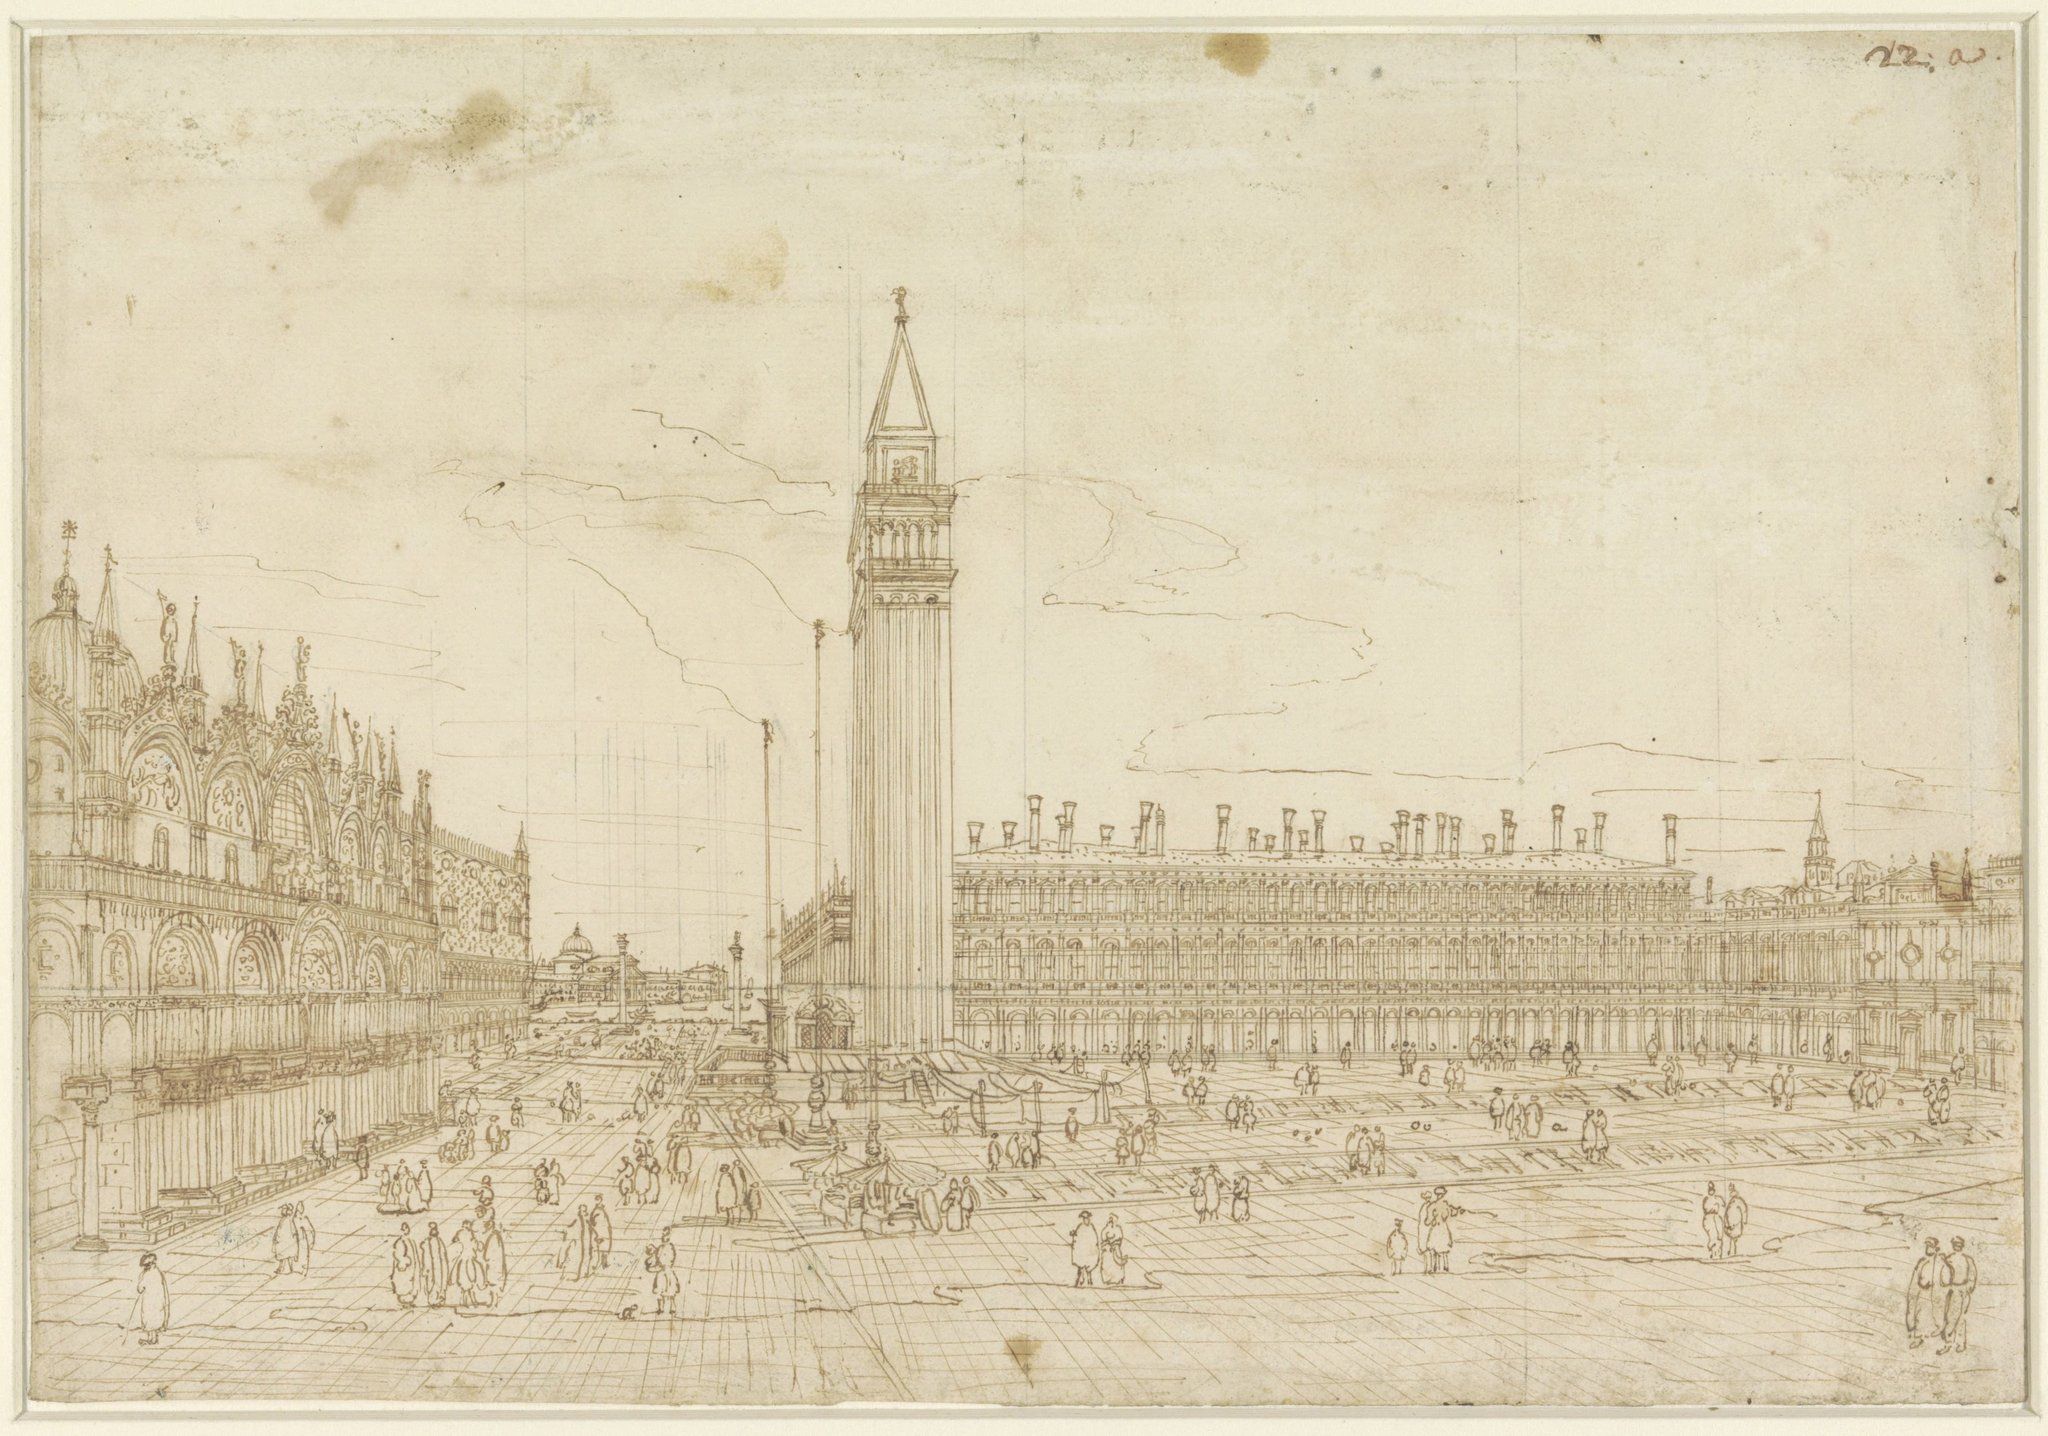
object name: drawing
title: De Piazza San Marco, in de richting van de Piazetta gezien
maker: bernardo bellotto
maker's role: draughtsman, painter, print maker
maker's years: 1721-1780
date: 1730-1780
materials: ink, paper, pencil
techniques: pen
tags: square, place, circus, etc., church (exterior), public road, italy, venice